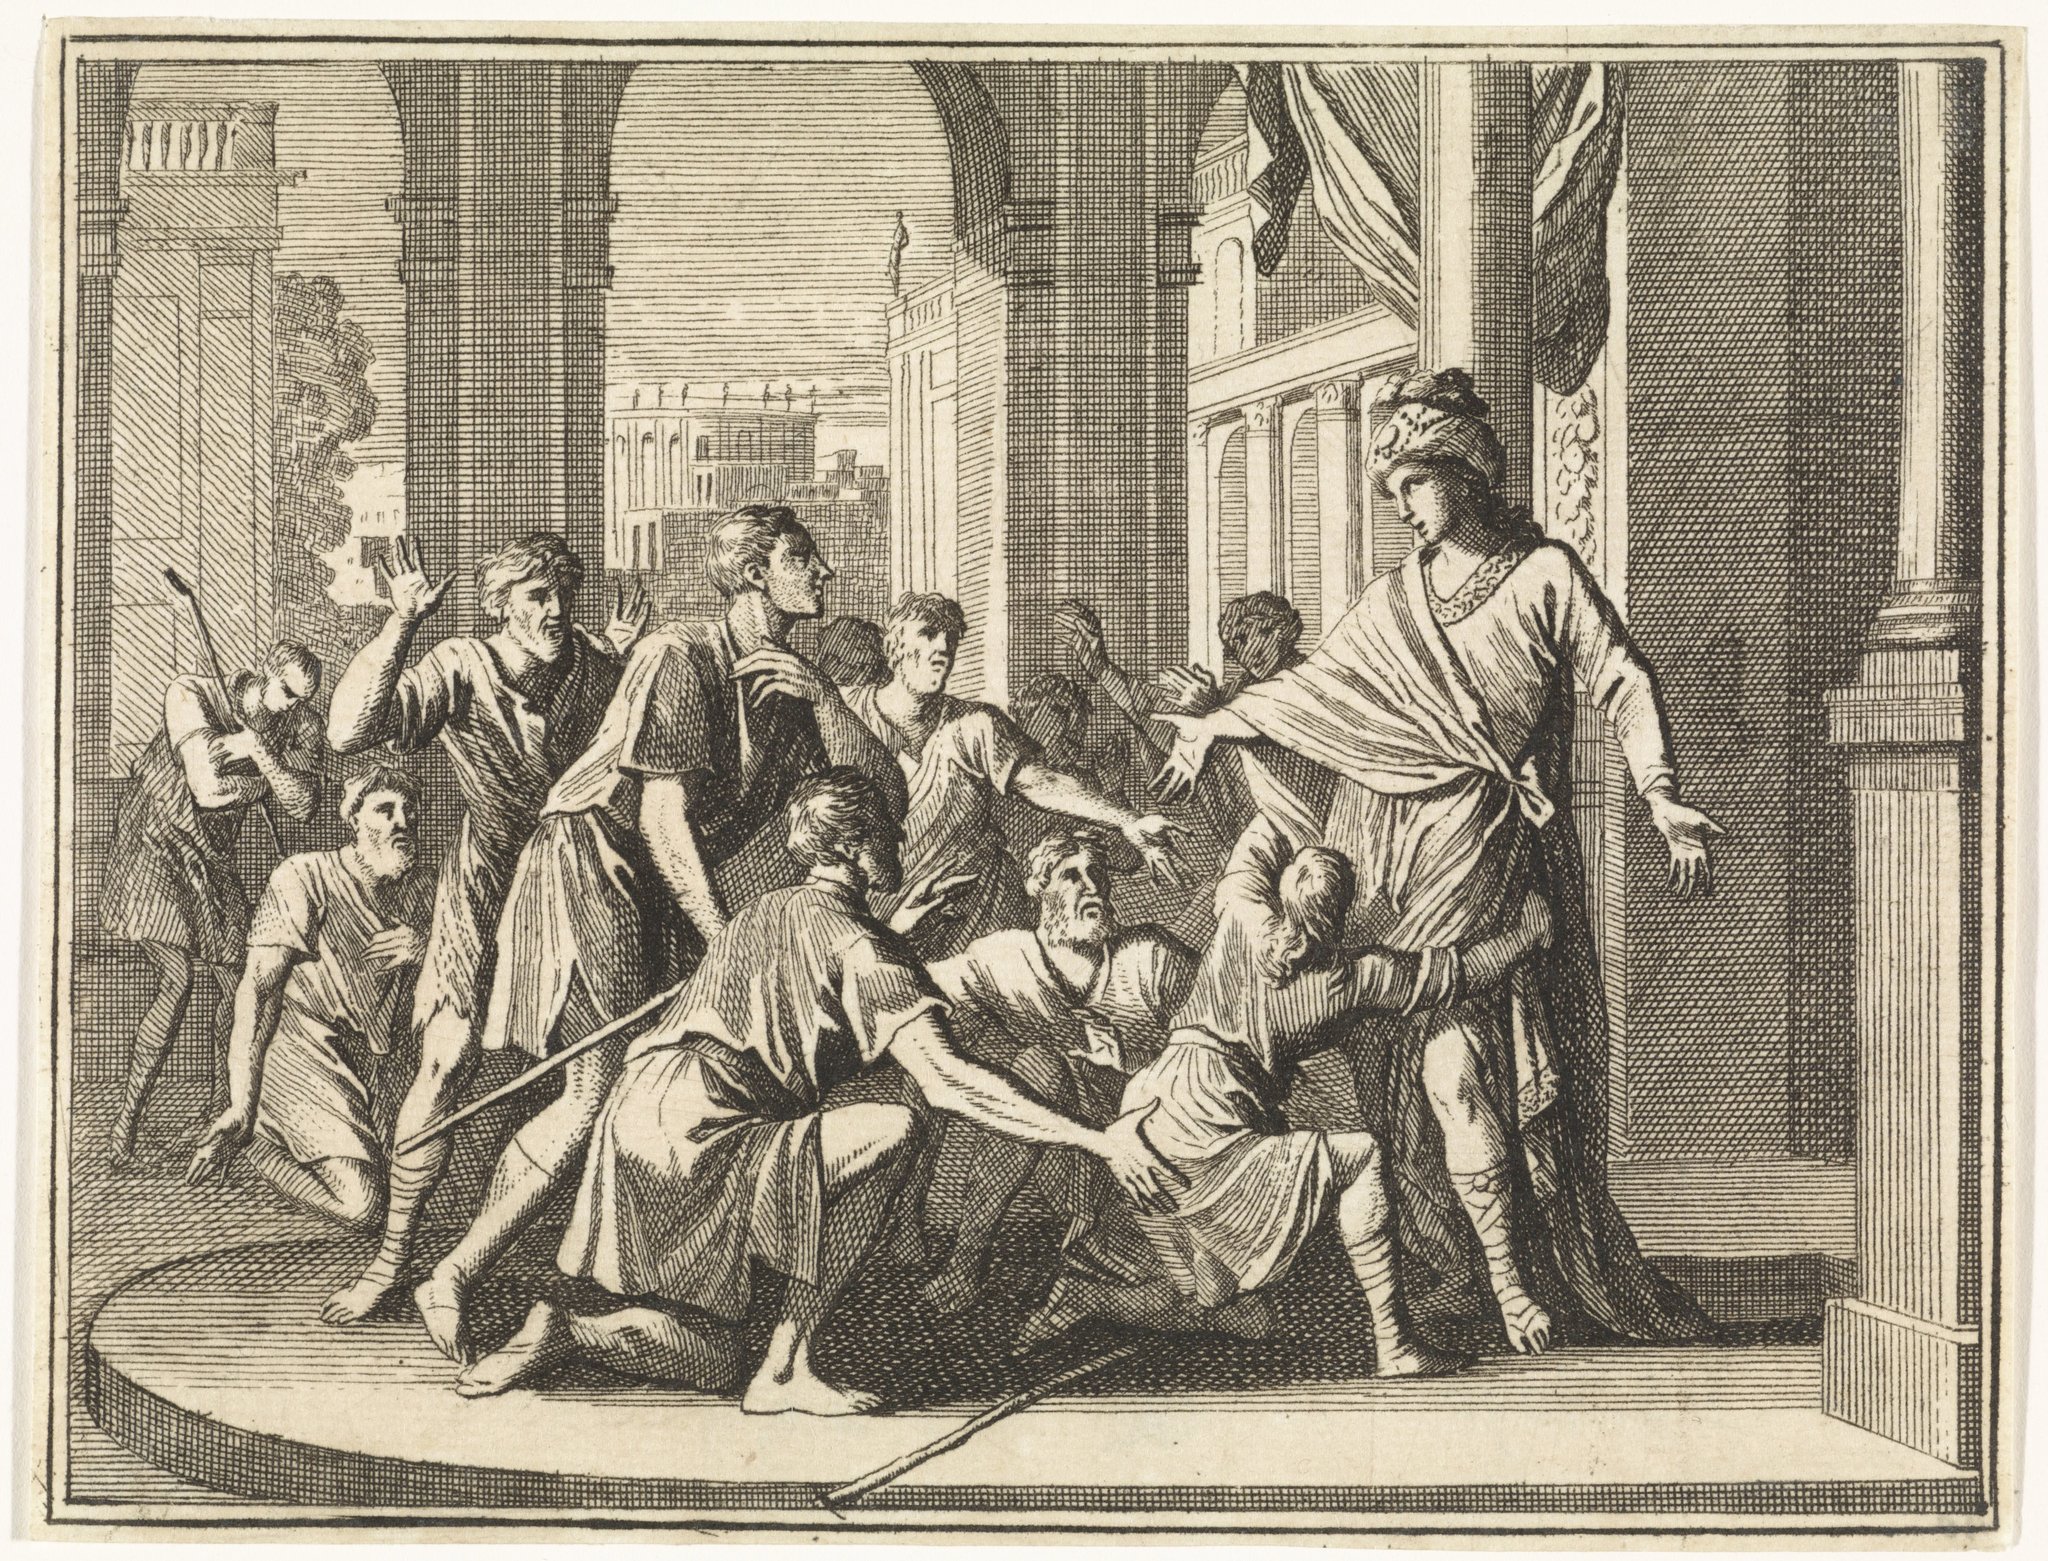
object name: print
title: Jozef maakt zich bekend aan zijn broers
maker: caspar luyken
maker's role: draughtsman, print maker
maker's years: 1672-1708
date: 1712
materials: paper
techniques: etching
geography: amsterdam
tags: joseph reveals his identity and in tears forgives his brothers' past misdeed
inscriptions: number: ‘40’, collector's mark: Lugt 2228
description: Illustratie uit: Luyken, Jan. De schriftuurlyke geschiedenissen en gelykenissen van het Oude en Nieuwe Verbond, 2 delen. Amsterdam: Wed. Pieter Arentsz II en Cornelis van der Sys, 1712, dl. I.